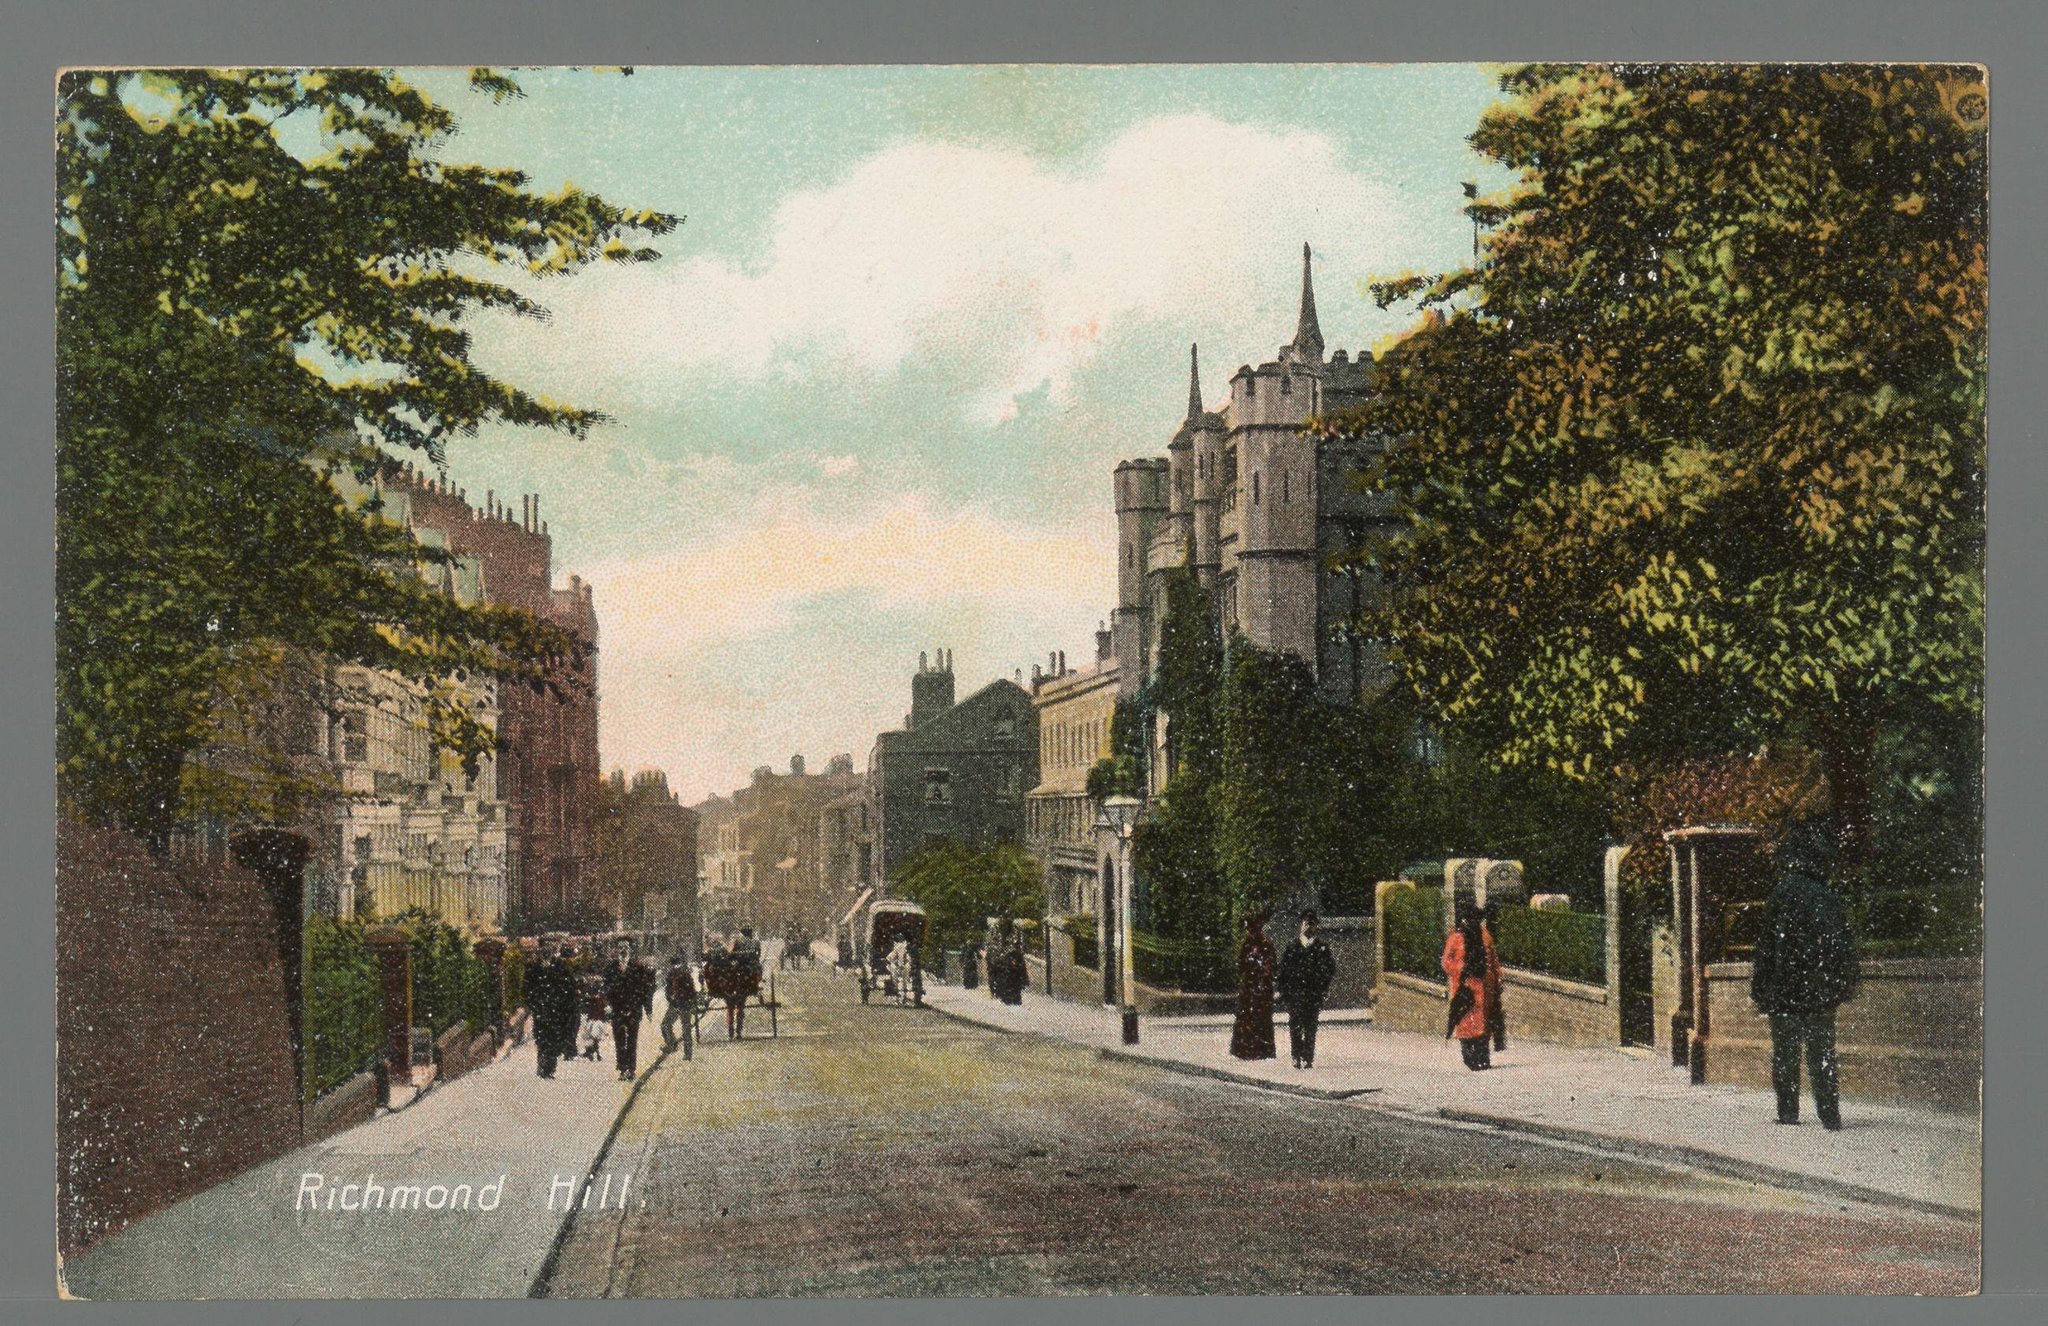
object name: photomechanical print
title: Richmond Hill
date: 1902-1930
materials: cardboard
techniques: lithograph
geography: glasgow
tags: (high) hill, street